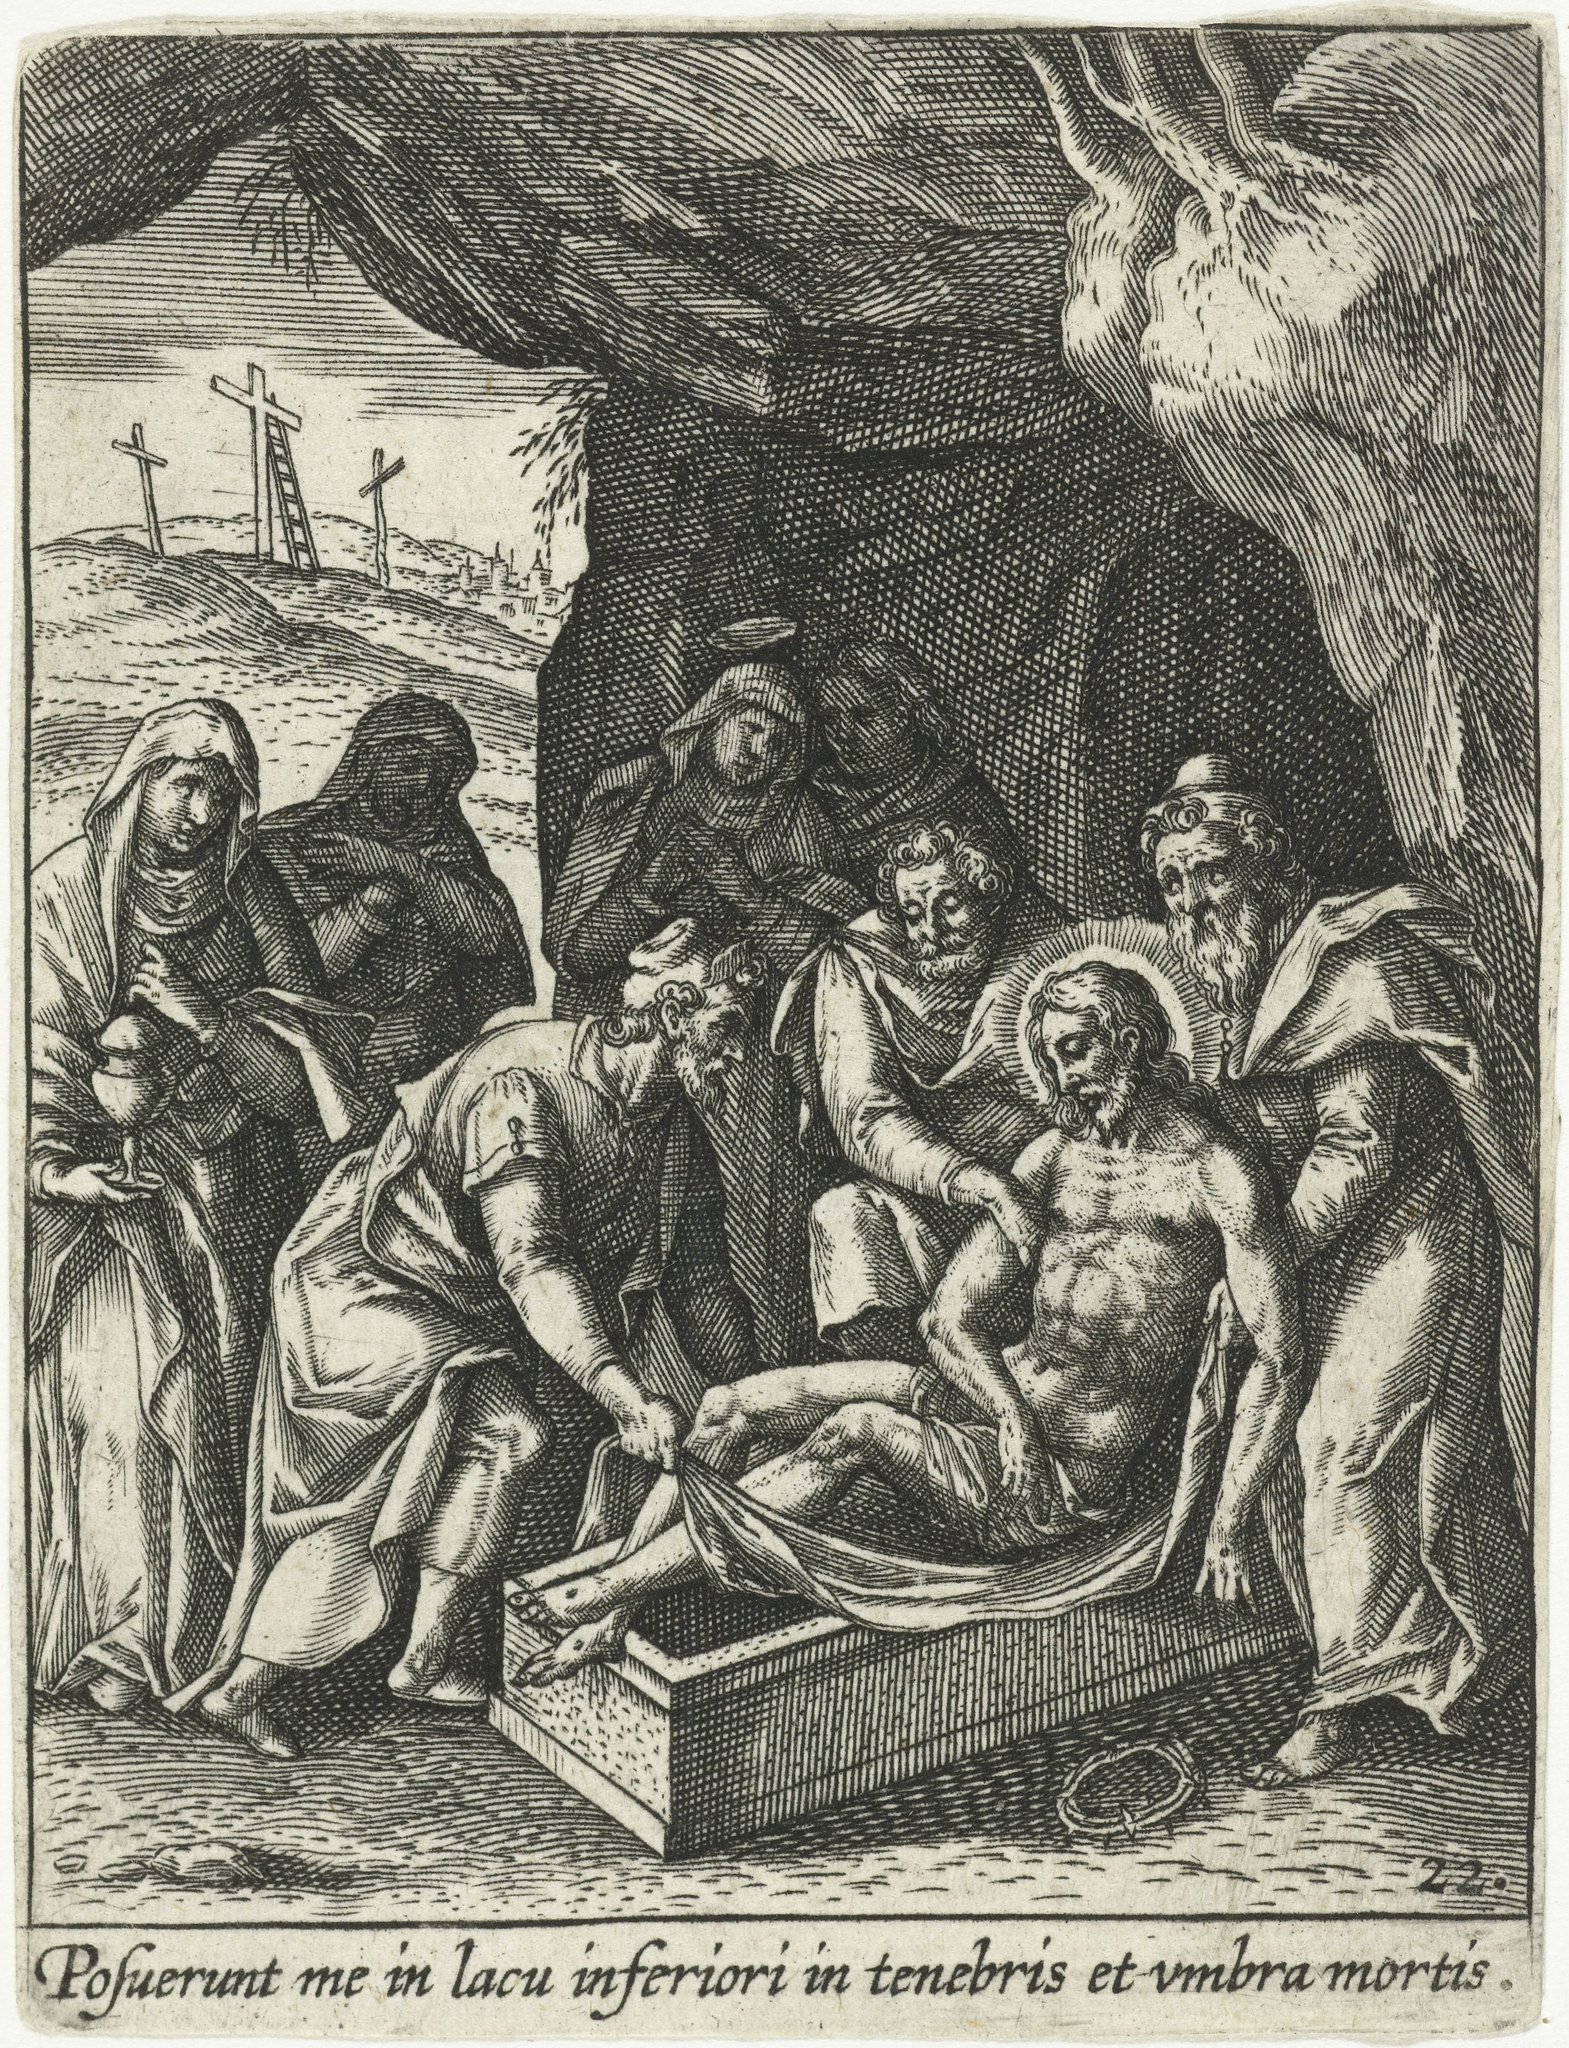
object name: print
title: Graflegging van Christus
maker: adriaen collaert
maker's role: draughtsman, print maker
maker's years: 1560-1618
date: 1570-1618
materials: paper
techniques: engraving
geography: antwerp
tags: christ's entombment (possibly by angels)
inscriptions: collector's mark: Lugt 240, collector's mark: Lugt 2228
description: Christus wordt door zijn familie en vrienden in een graftombe gelegd. De prent heeft een Latijns onderschrift